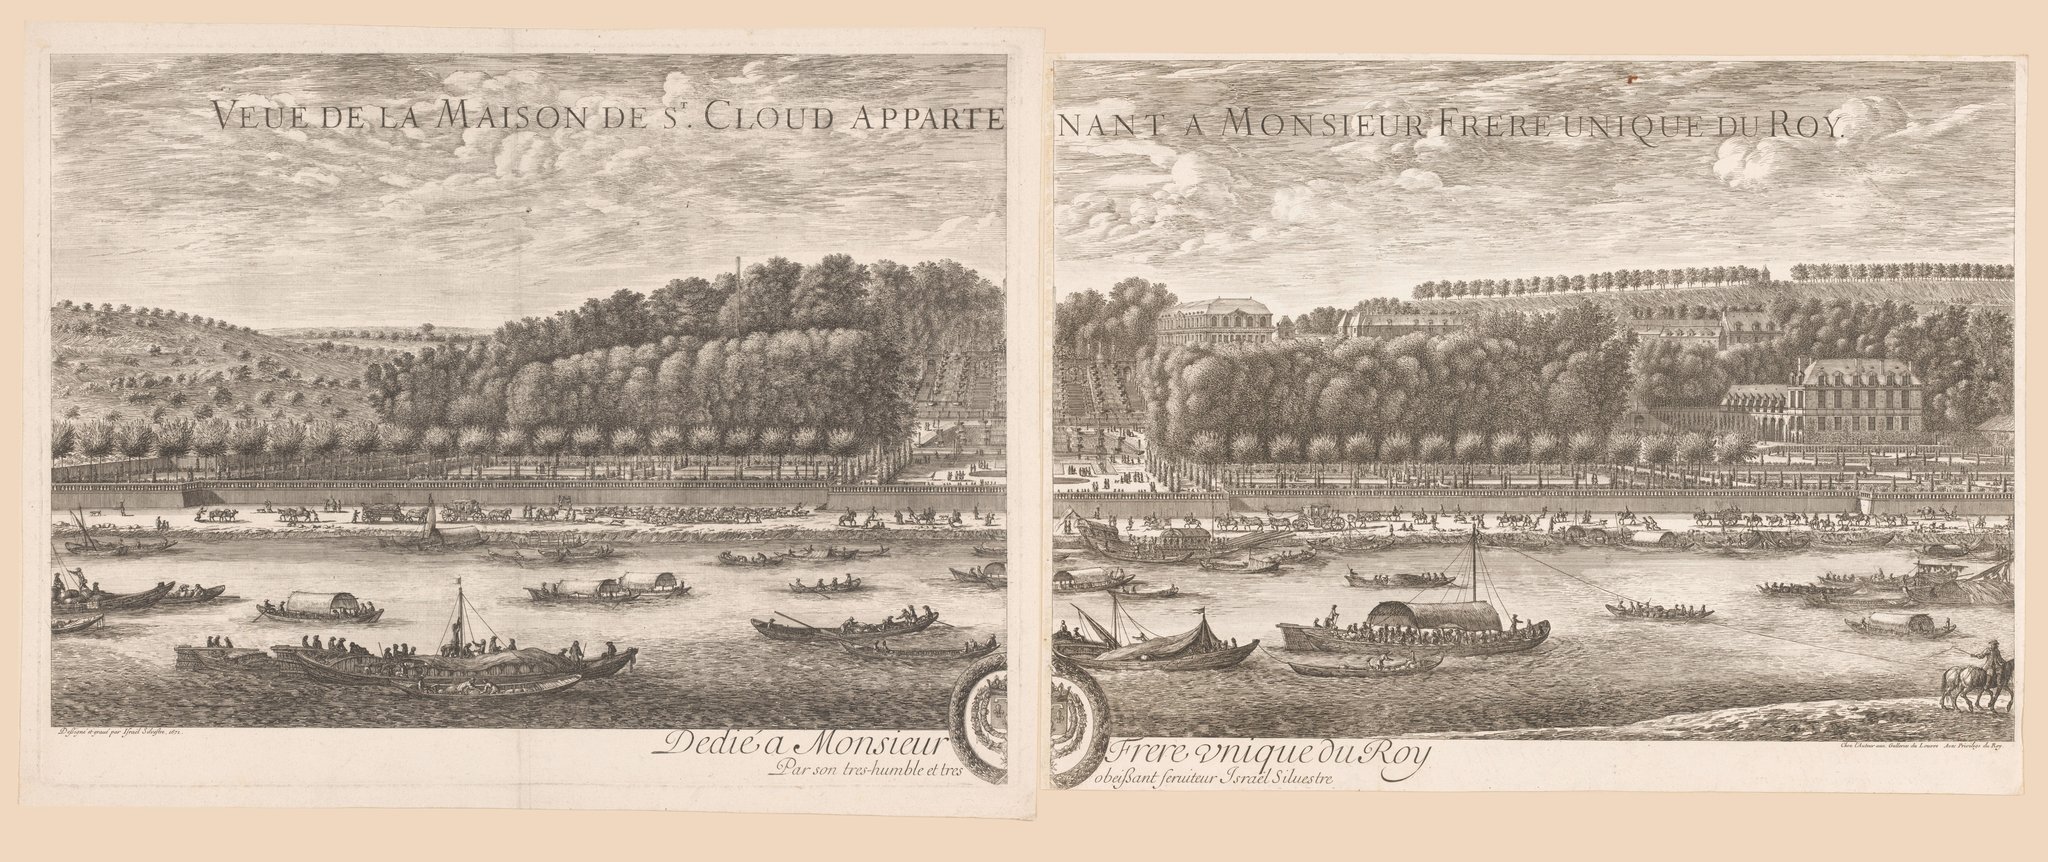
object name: print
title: Veue de la maison de St. Cloud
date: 1671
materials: paper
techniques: engraving, etching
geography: france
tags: city-view, and landscape with man-made constructions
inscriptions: collector's mark: Lugt 240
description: Dit object is omwille van een betere presentatie virtueel samengevoegd, maar bestaat fysiek uit losse onderdelen.